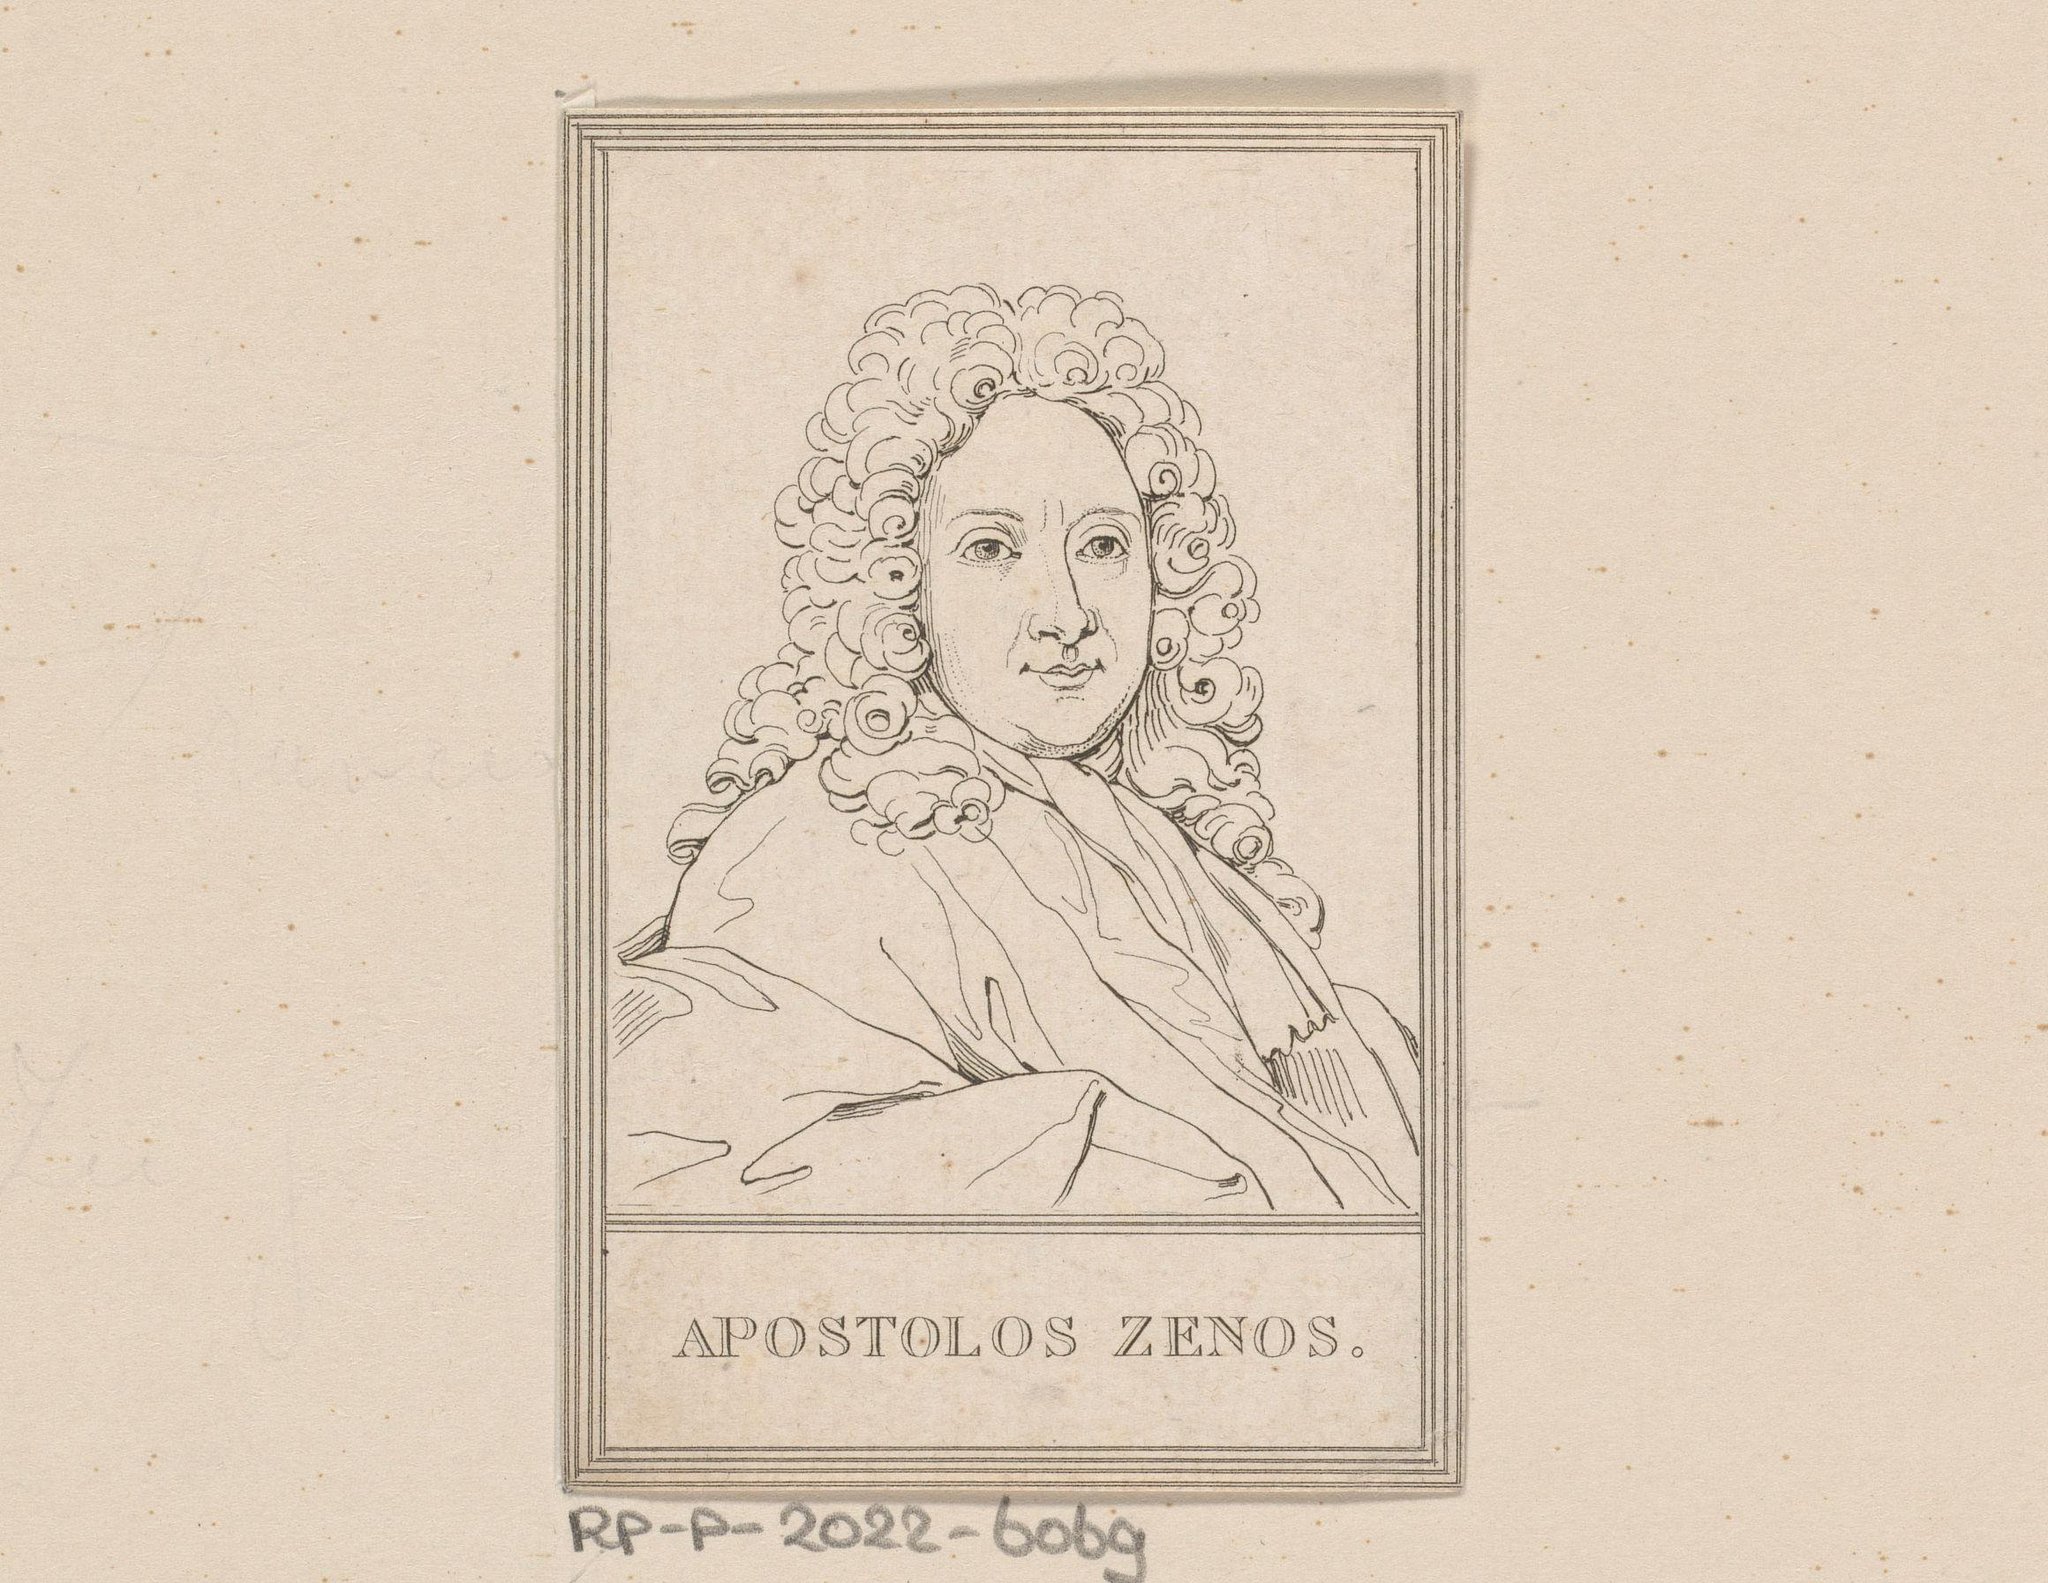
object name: book illustration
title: Portret van Apostolo Zeno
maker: Anonymous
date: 1811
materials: paper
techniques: etching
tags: journalist, reporter, historical persons, portrait of a writer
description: Prent waarschijnlijk uit: Galerie historique des hommes les plus célèbres (...). Parijs: Charles Paul Landon, 1811, dl. 13.